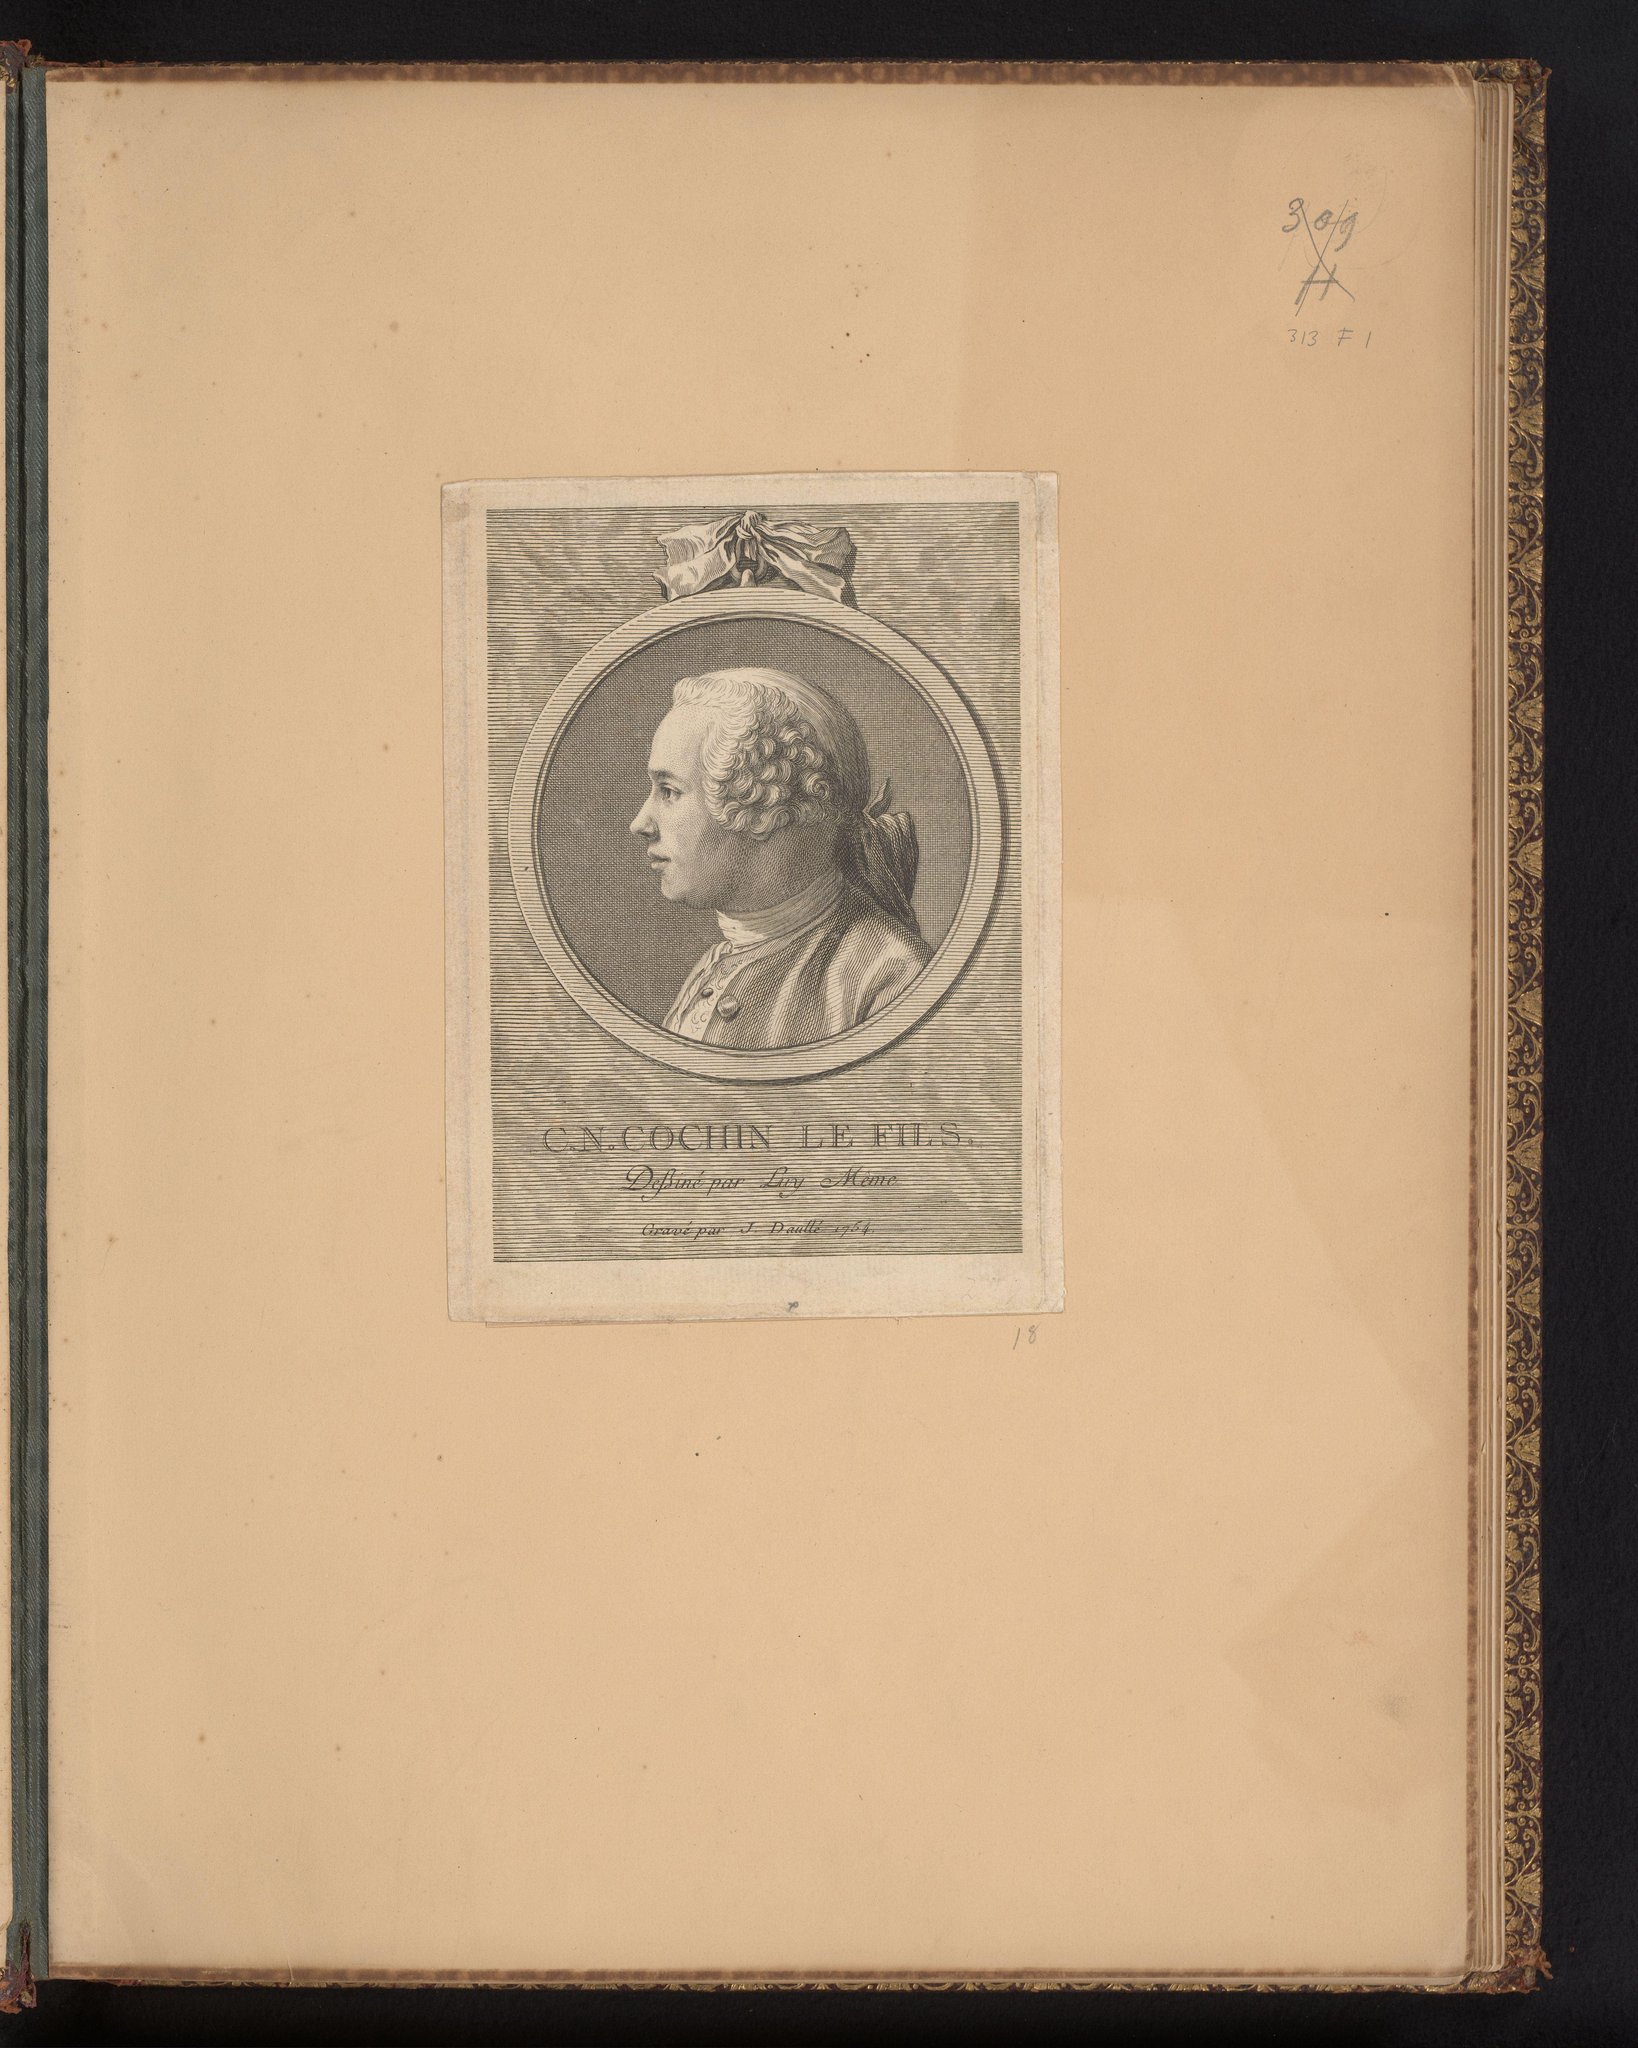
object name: print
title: Portret van Charles Nicolas Cochin II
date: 1754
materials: paper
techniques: engraving, etching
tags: paris, print maker, charles nicolas cochin (ii), historical persons, portrait, self-portrait of graphic artist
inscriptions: date